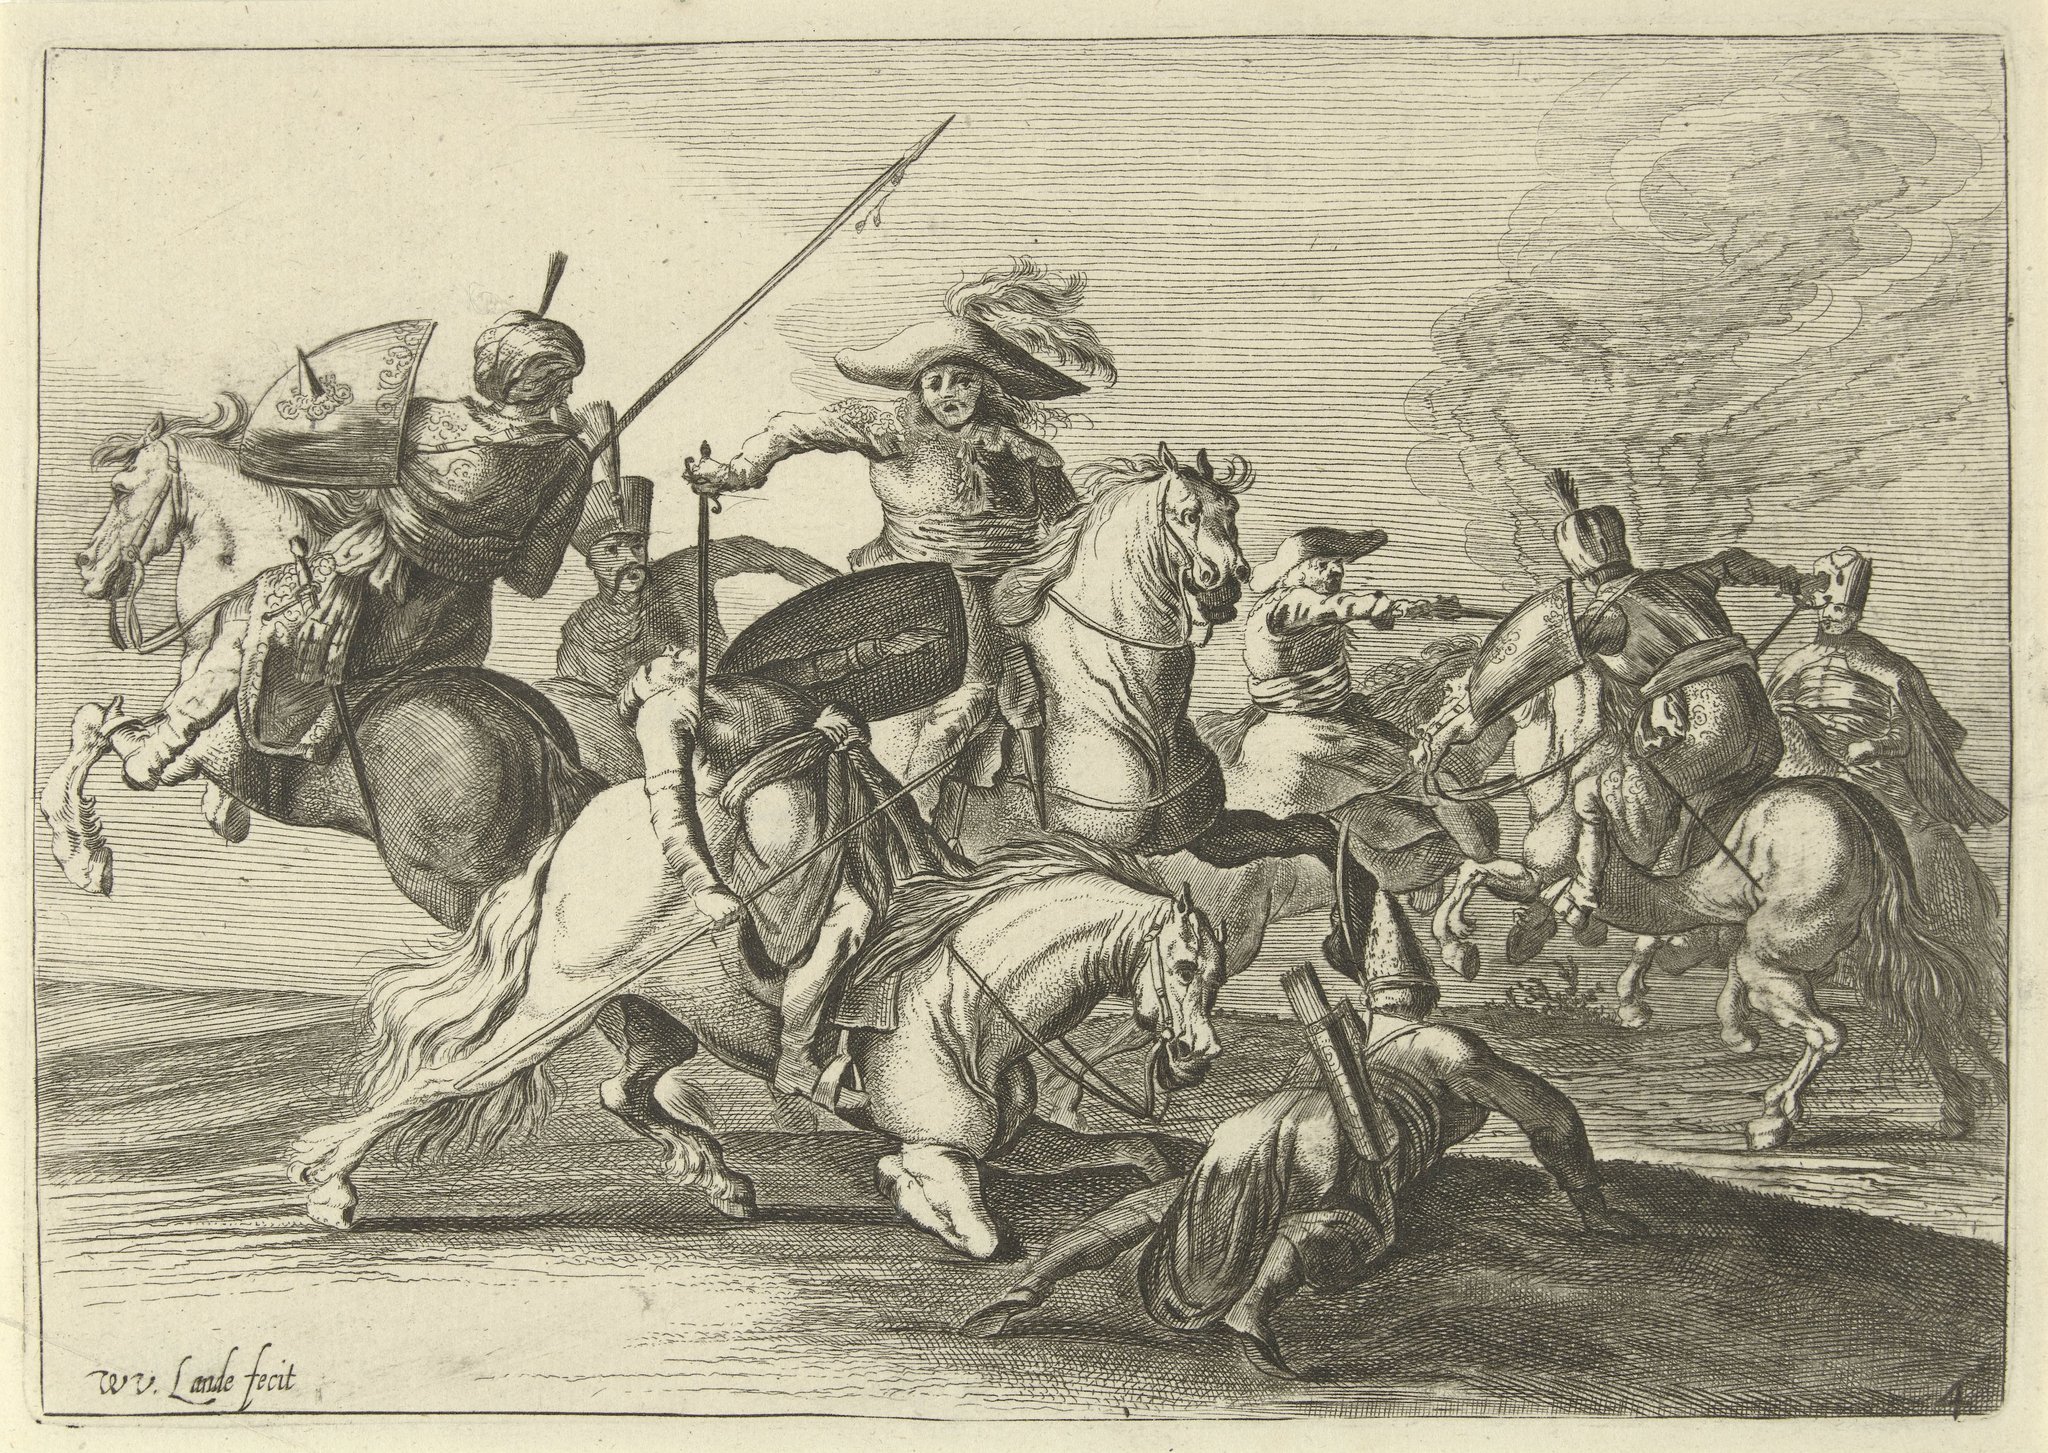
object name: print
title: Ruitergevechten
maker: willem van de lande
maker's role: print maker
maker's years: 1610-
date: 1635-1650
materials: paper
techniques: etching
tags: riding a horse, ass, or mule; rider, horseman, battle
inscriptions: collector's mark: Lugt 2228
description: Slagveldscène waarin een ruiter in Westerse kledij te paard een Turkse tegenstander neersabelt. De prent maakt deel uit van een zesdelige serie prenten met ruitergevechten. Prent rechtsonder genummerd: 4.